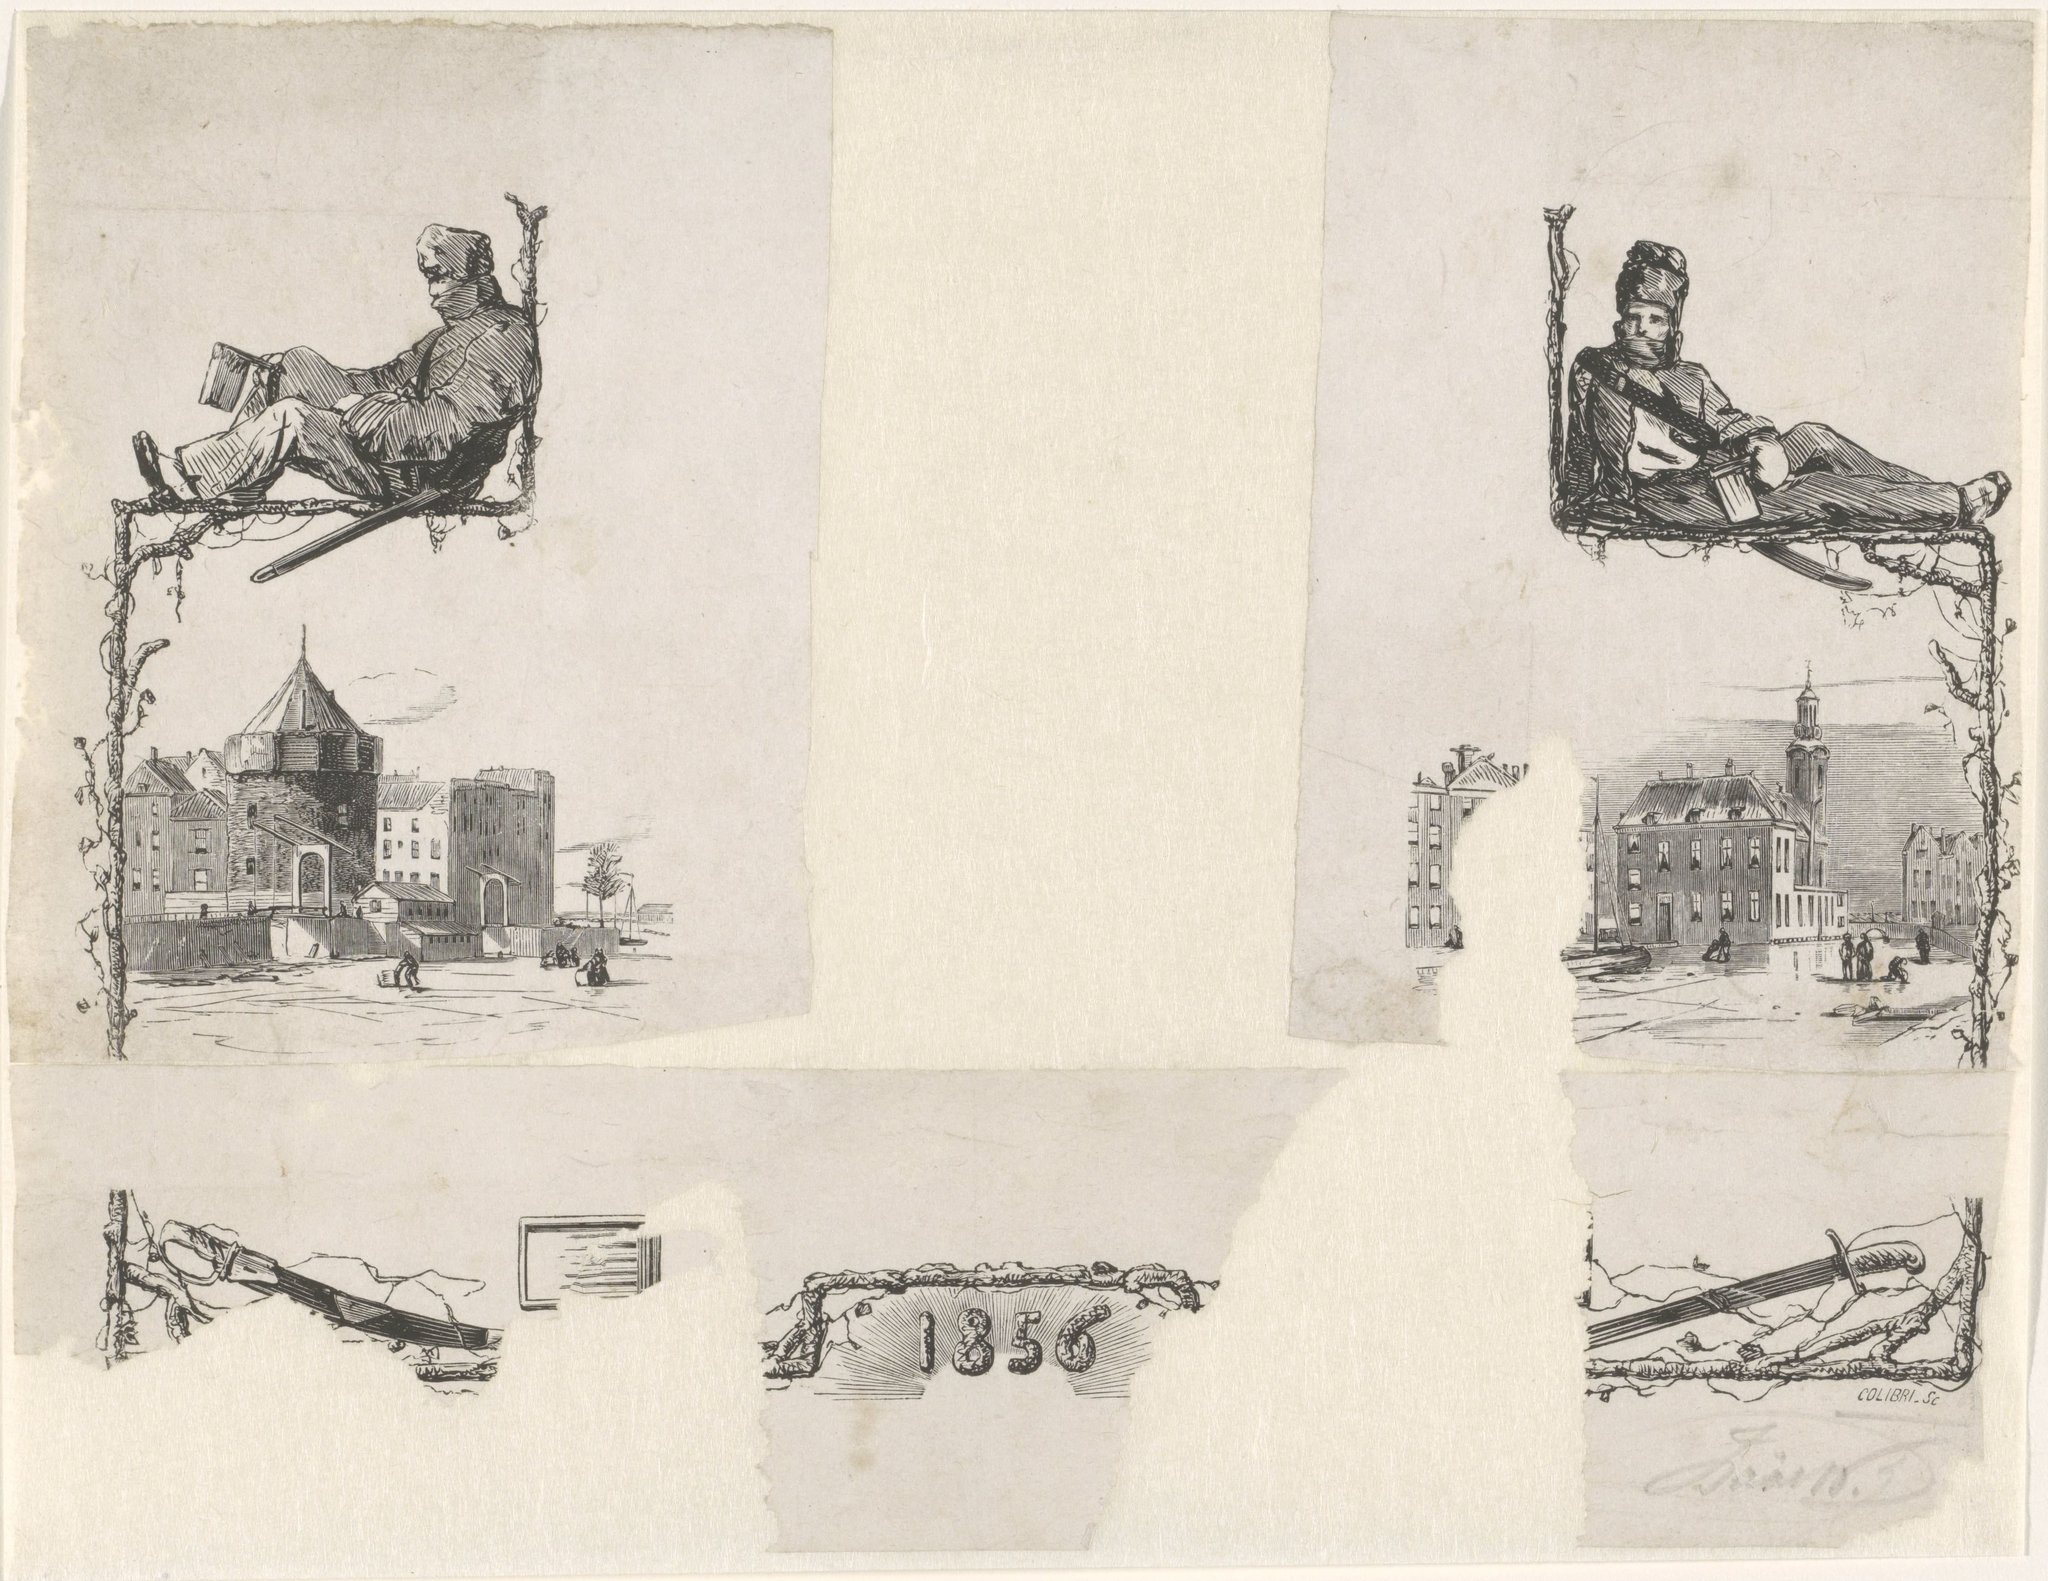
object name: print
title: Geornamenteerde omlijsting met twee stadsgezichten te Amsterdam, twee zittende figuren en het jaartal '1856'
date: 1856-1912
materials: paper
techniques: engraving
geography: netherlands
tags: adult man (+ sitting on the ground), square, place, circus, etc. (+ city(-scape) with figures, staffage), street (+ city(-scape) with figures, staffage)